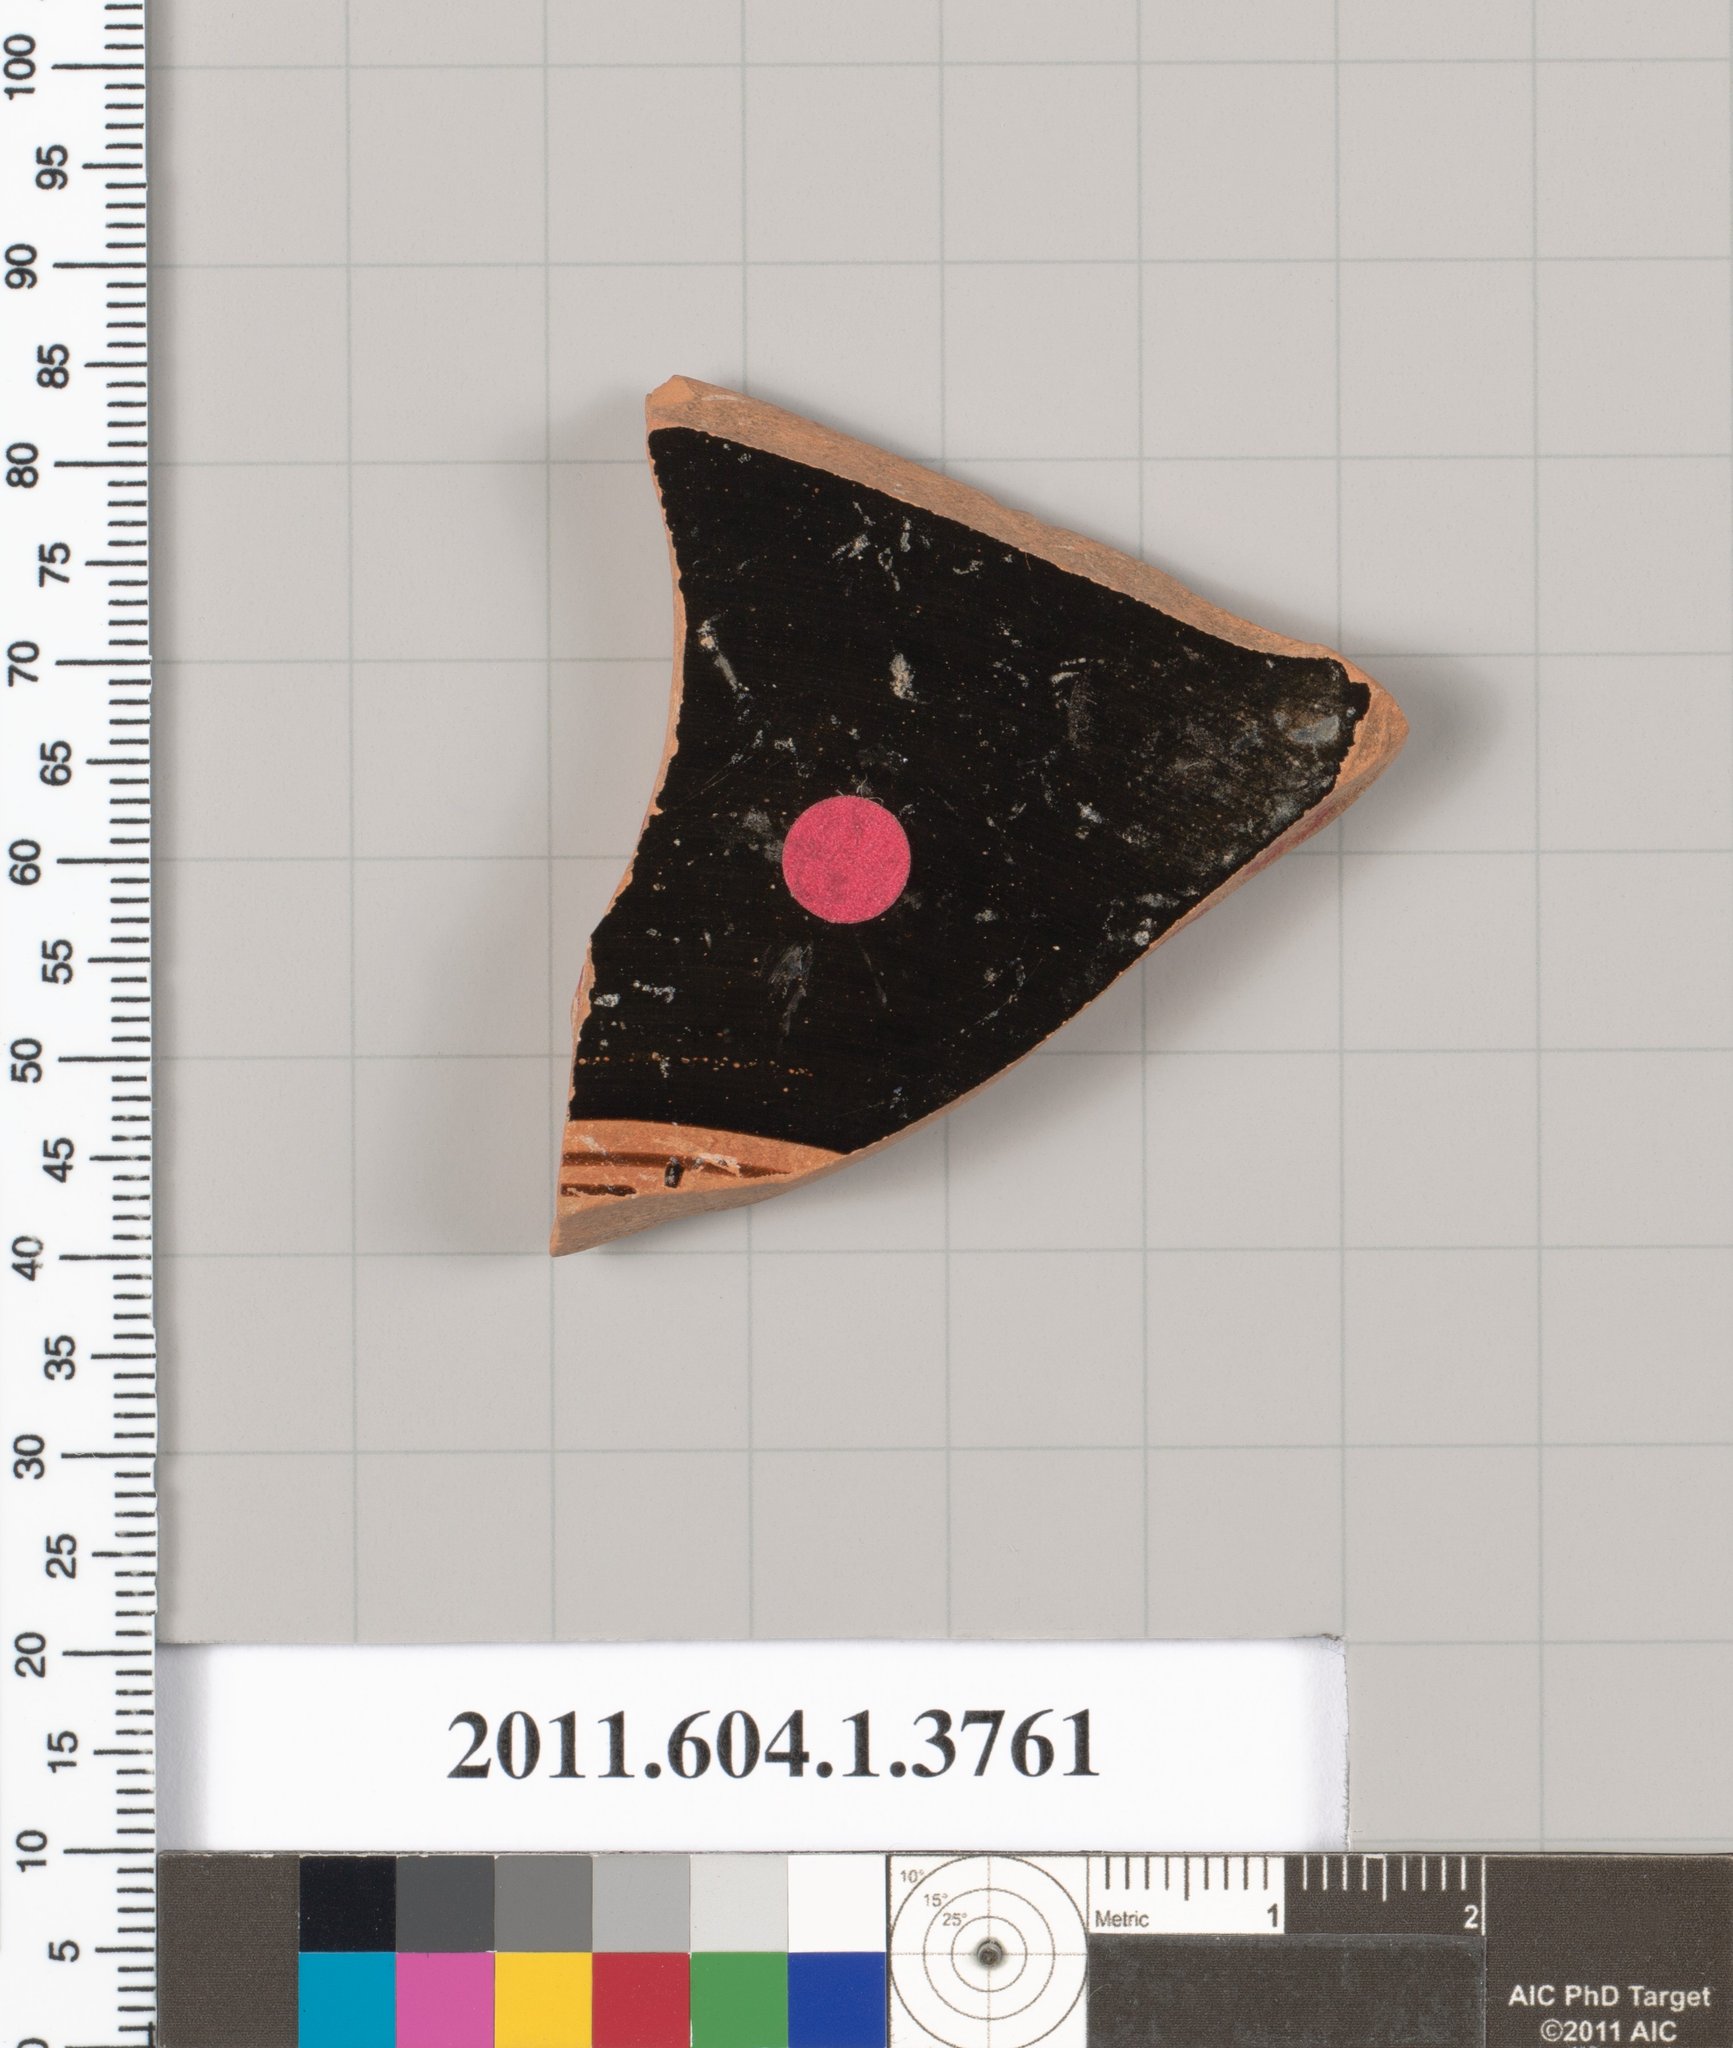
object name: kylix fragment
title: Terracotta fragment of a kylix (drinking cup)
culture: greek, attic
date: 470-450 BCE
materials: terracotta